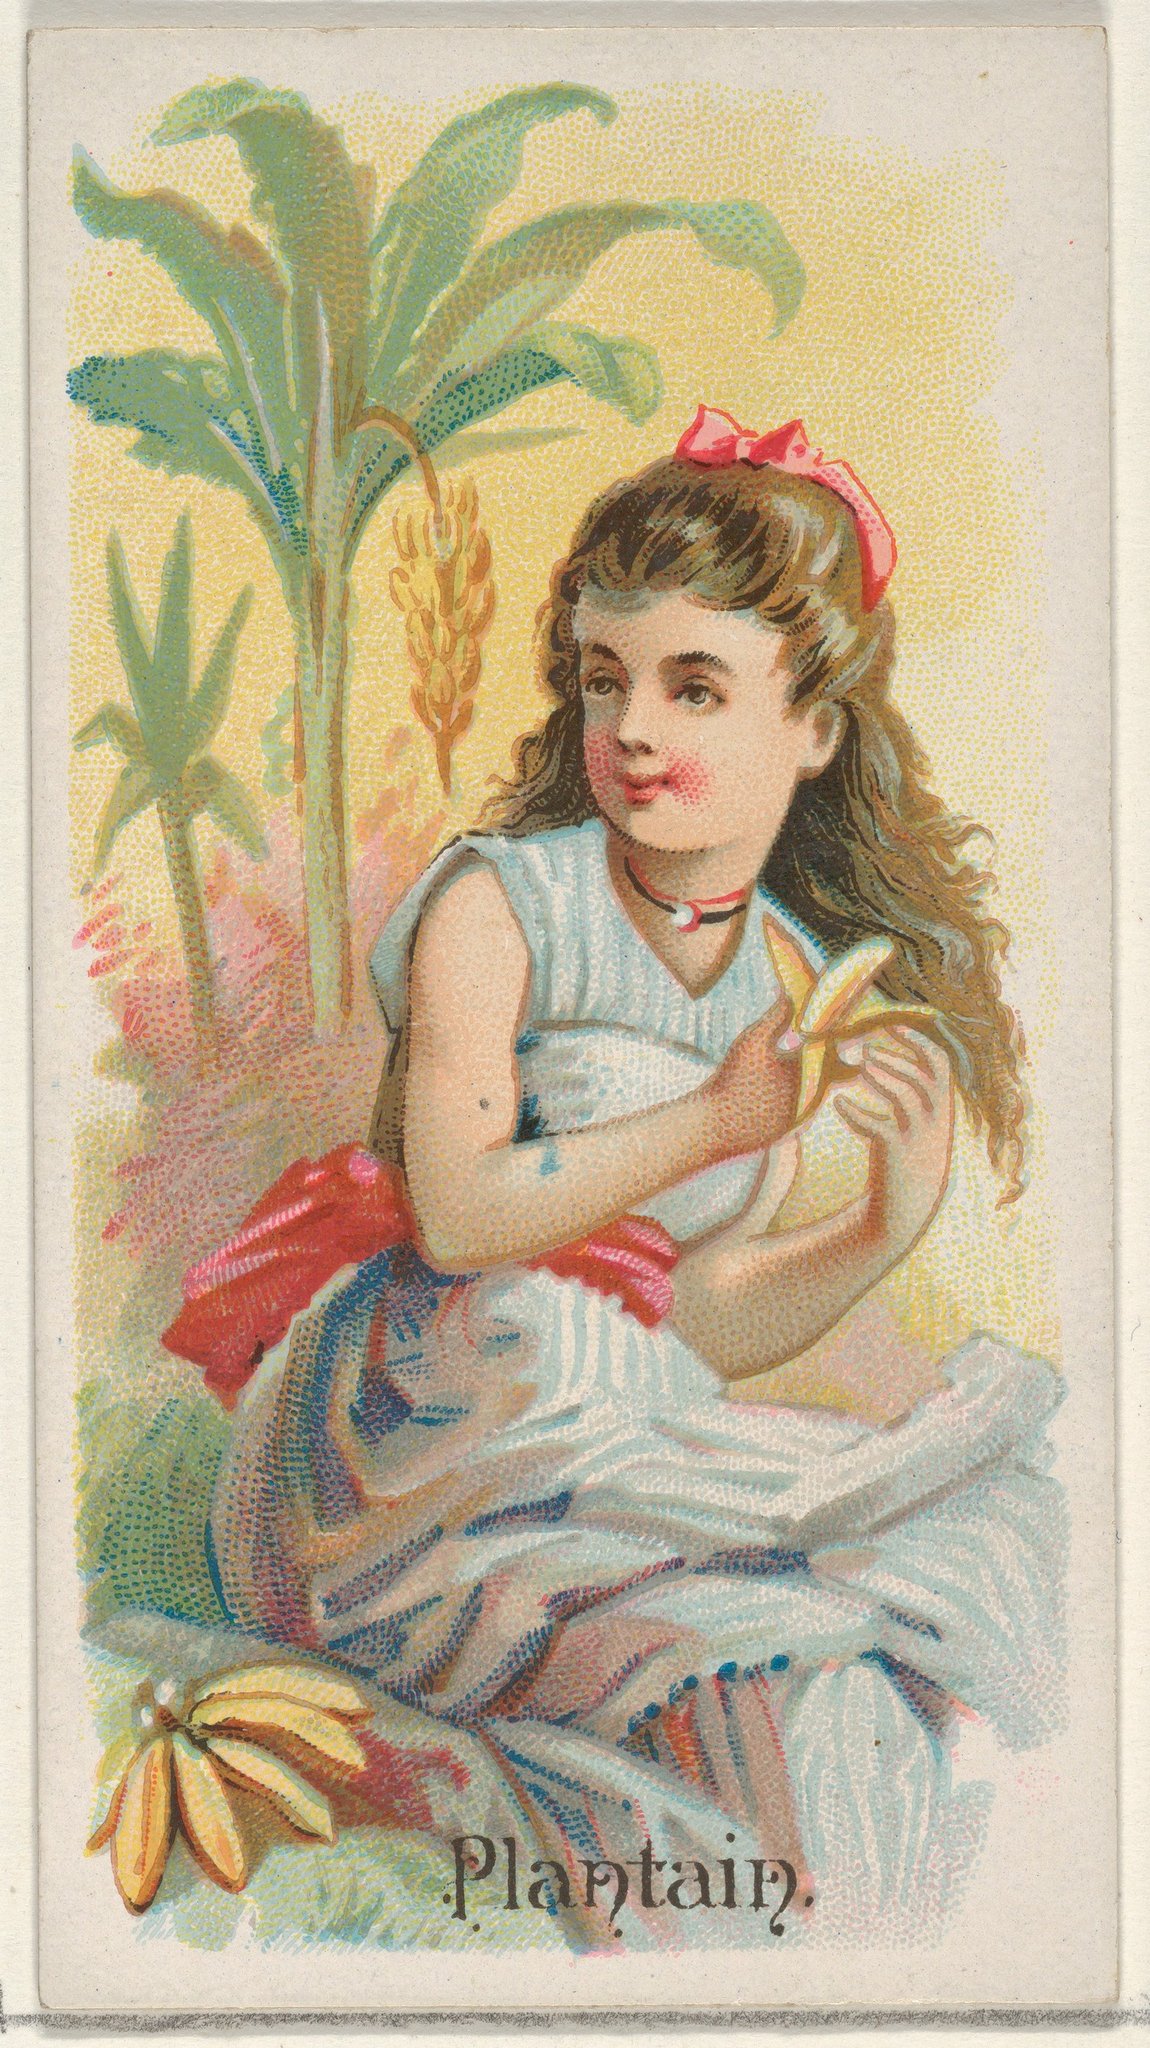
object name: print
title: Plantain, from the Fruits series (N12) for Allen & Ginter Cigarettes Brands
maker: allen & ginter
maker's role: publisher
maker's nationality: american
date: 1891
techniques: color lithograph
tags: fruit,girls